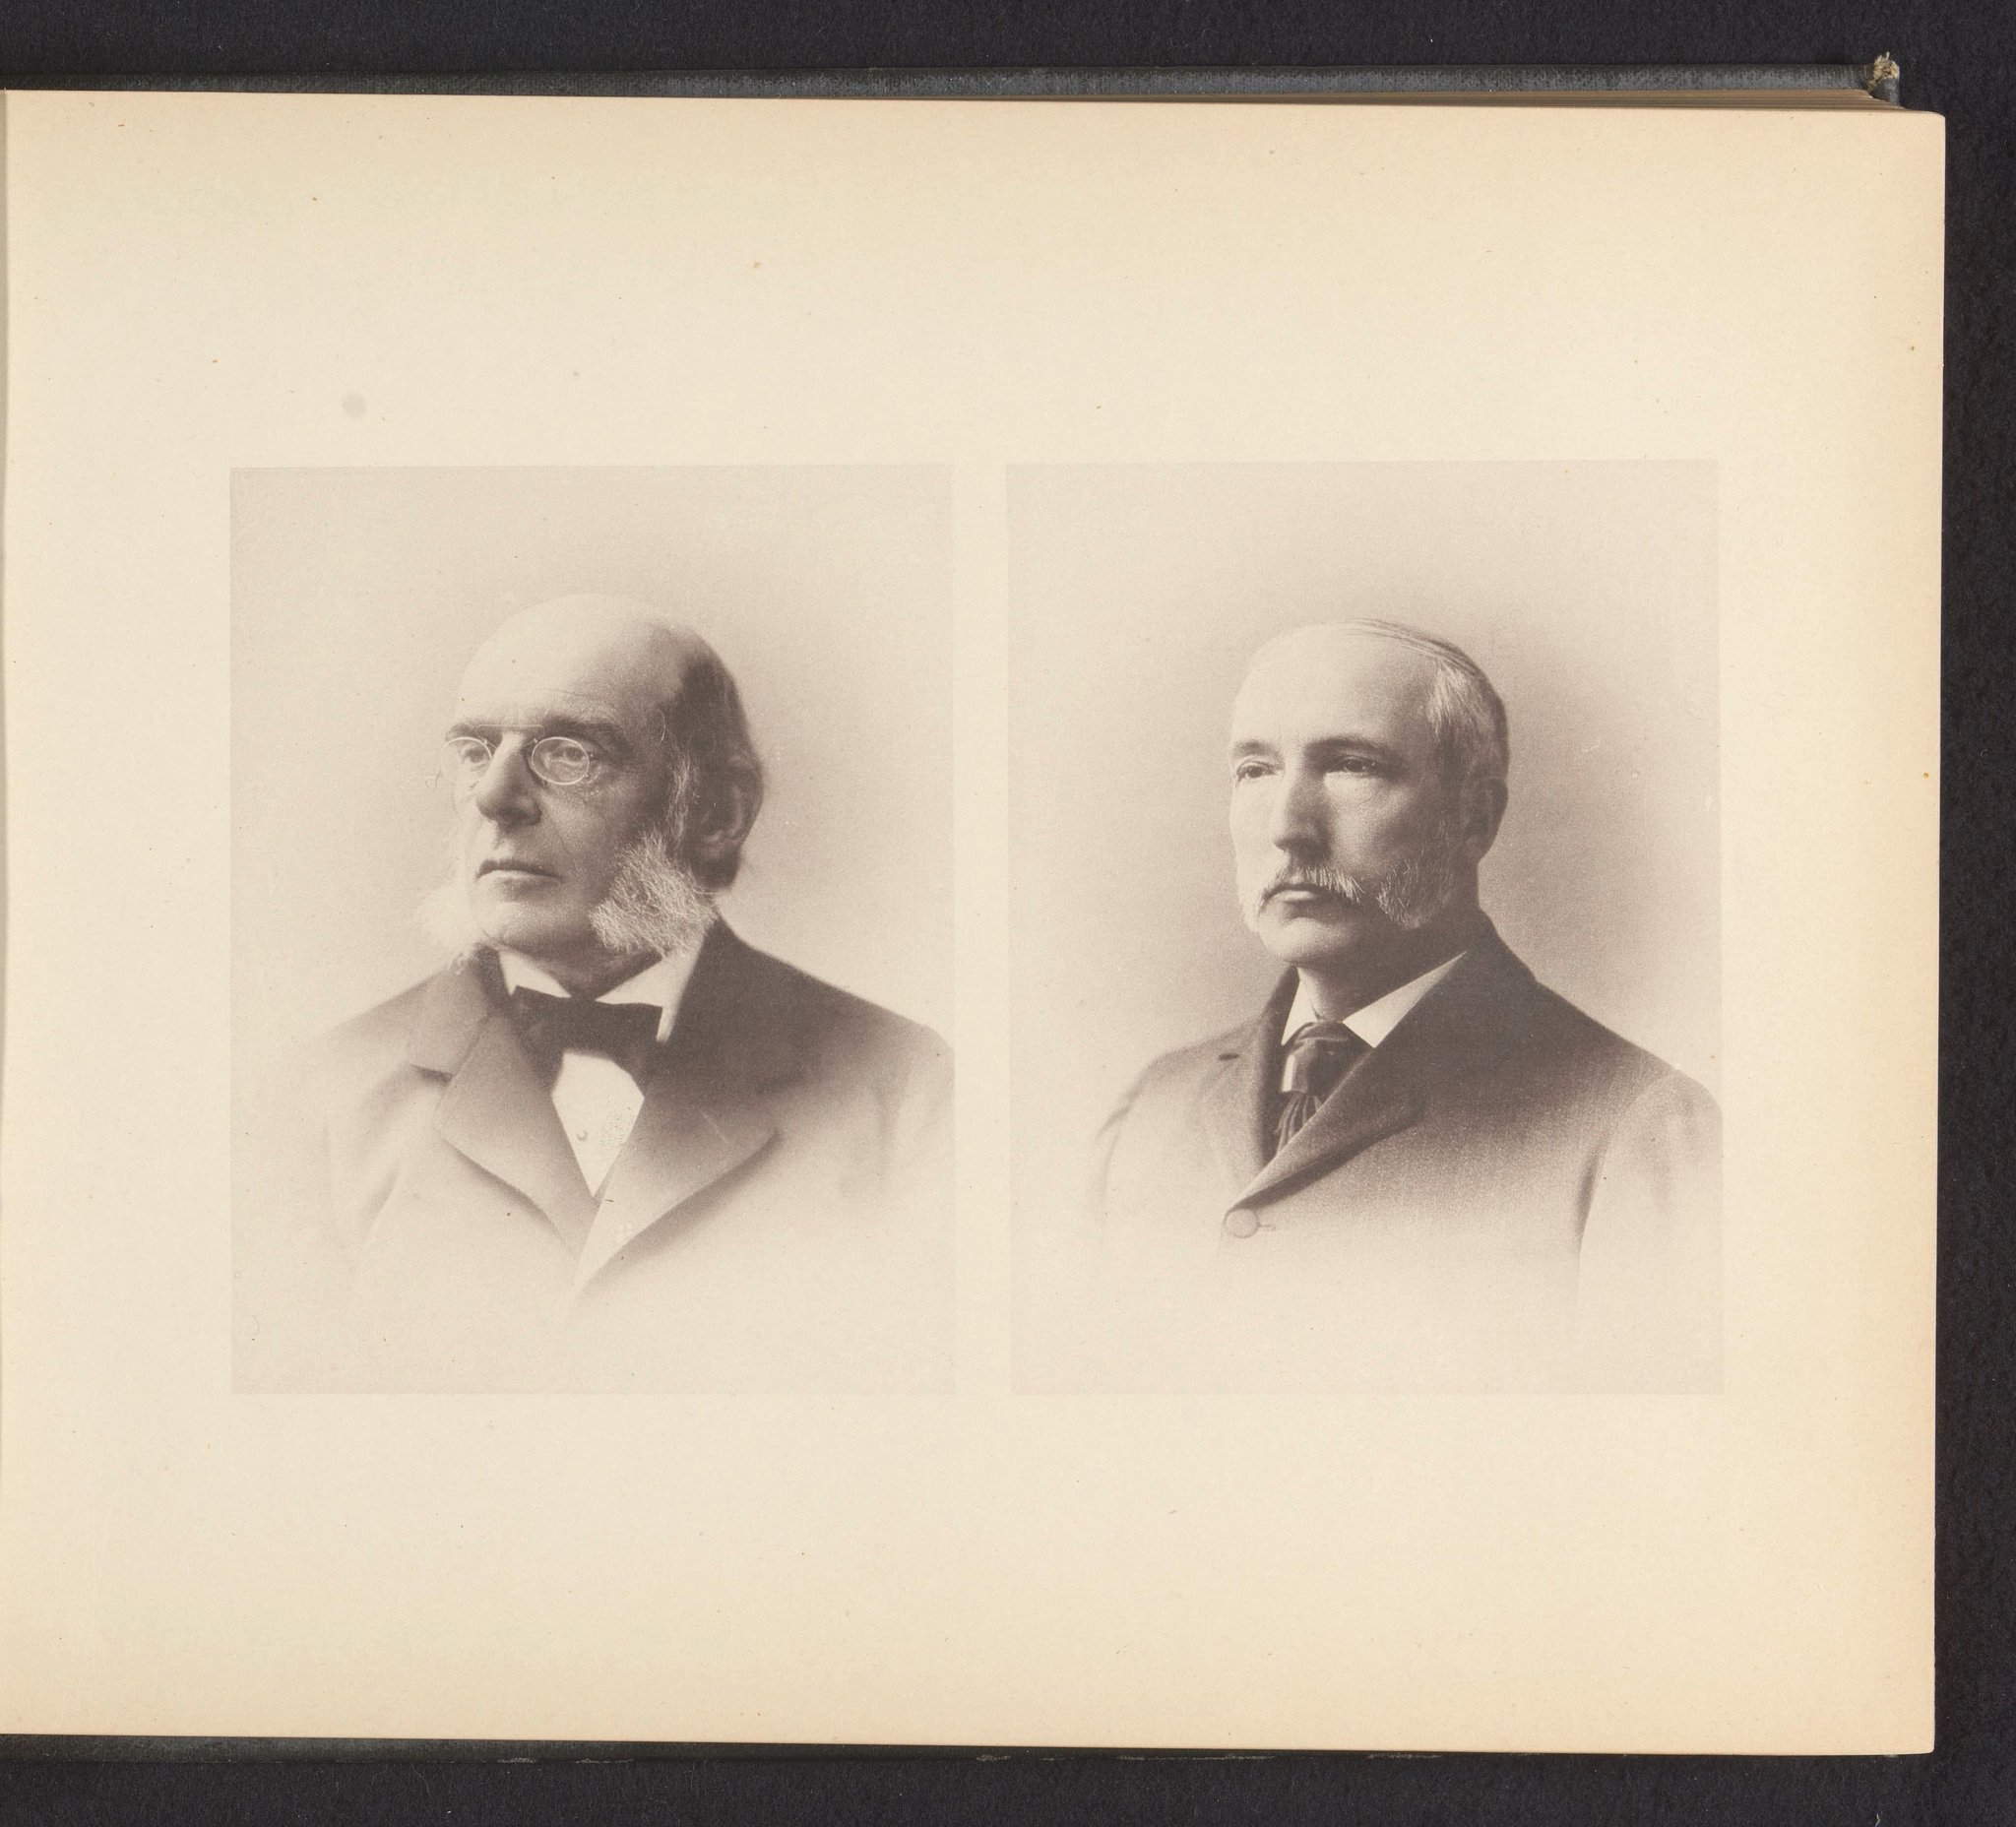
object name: photomechanical print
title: Portret van Timothy Dwight en een portret van Henry Parks Wright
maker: Anonymous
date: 1895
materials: paper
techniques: photograph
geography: new york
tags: professor